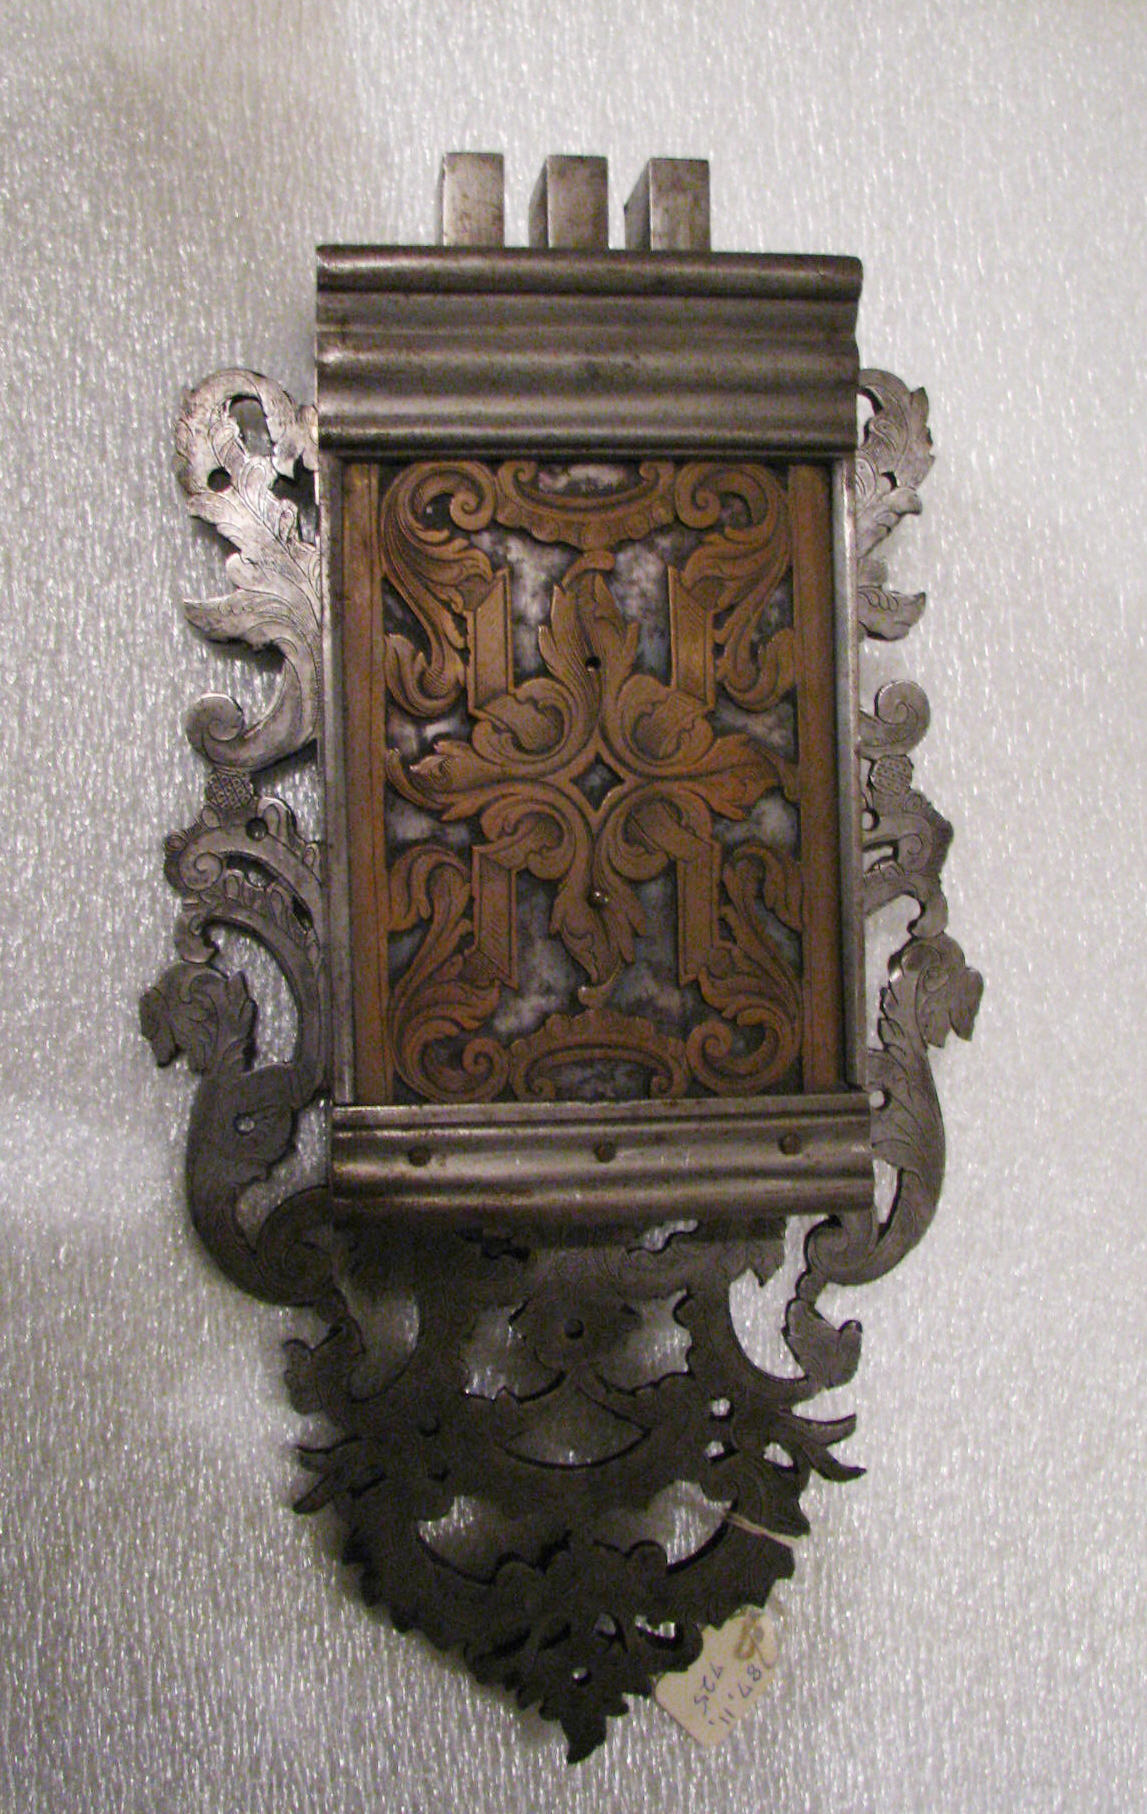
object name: rim lock box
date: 1710-1740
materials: iron